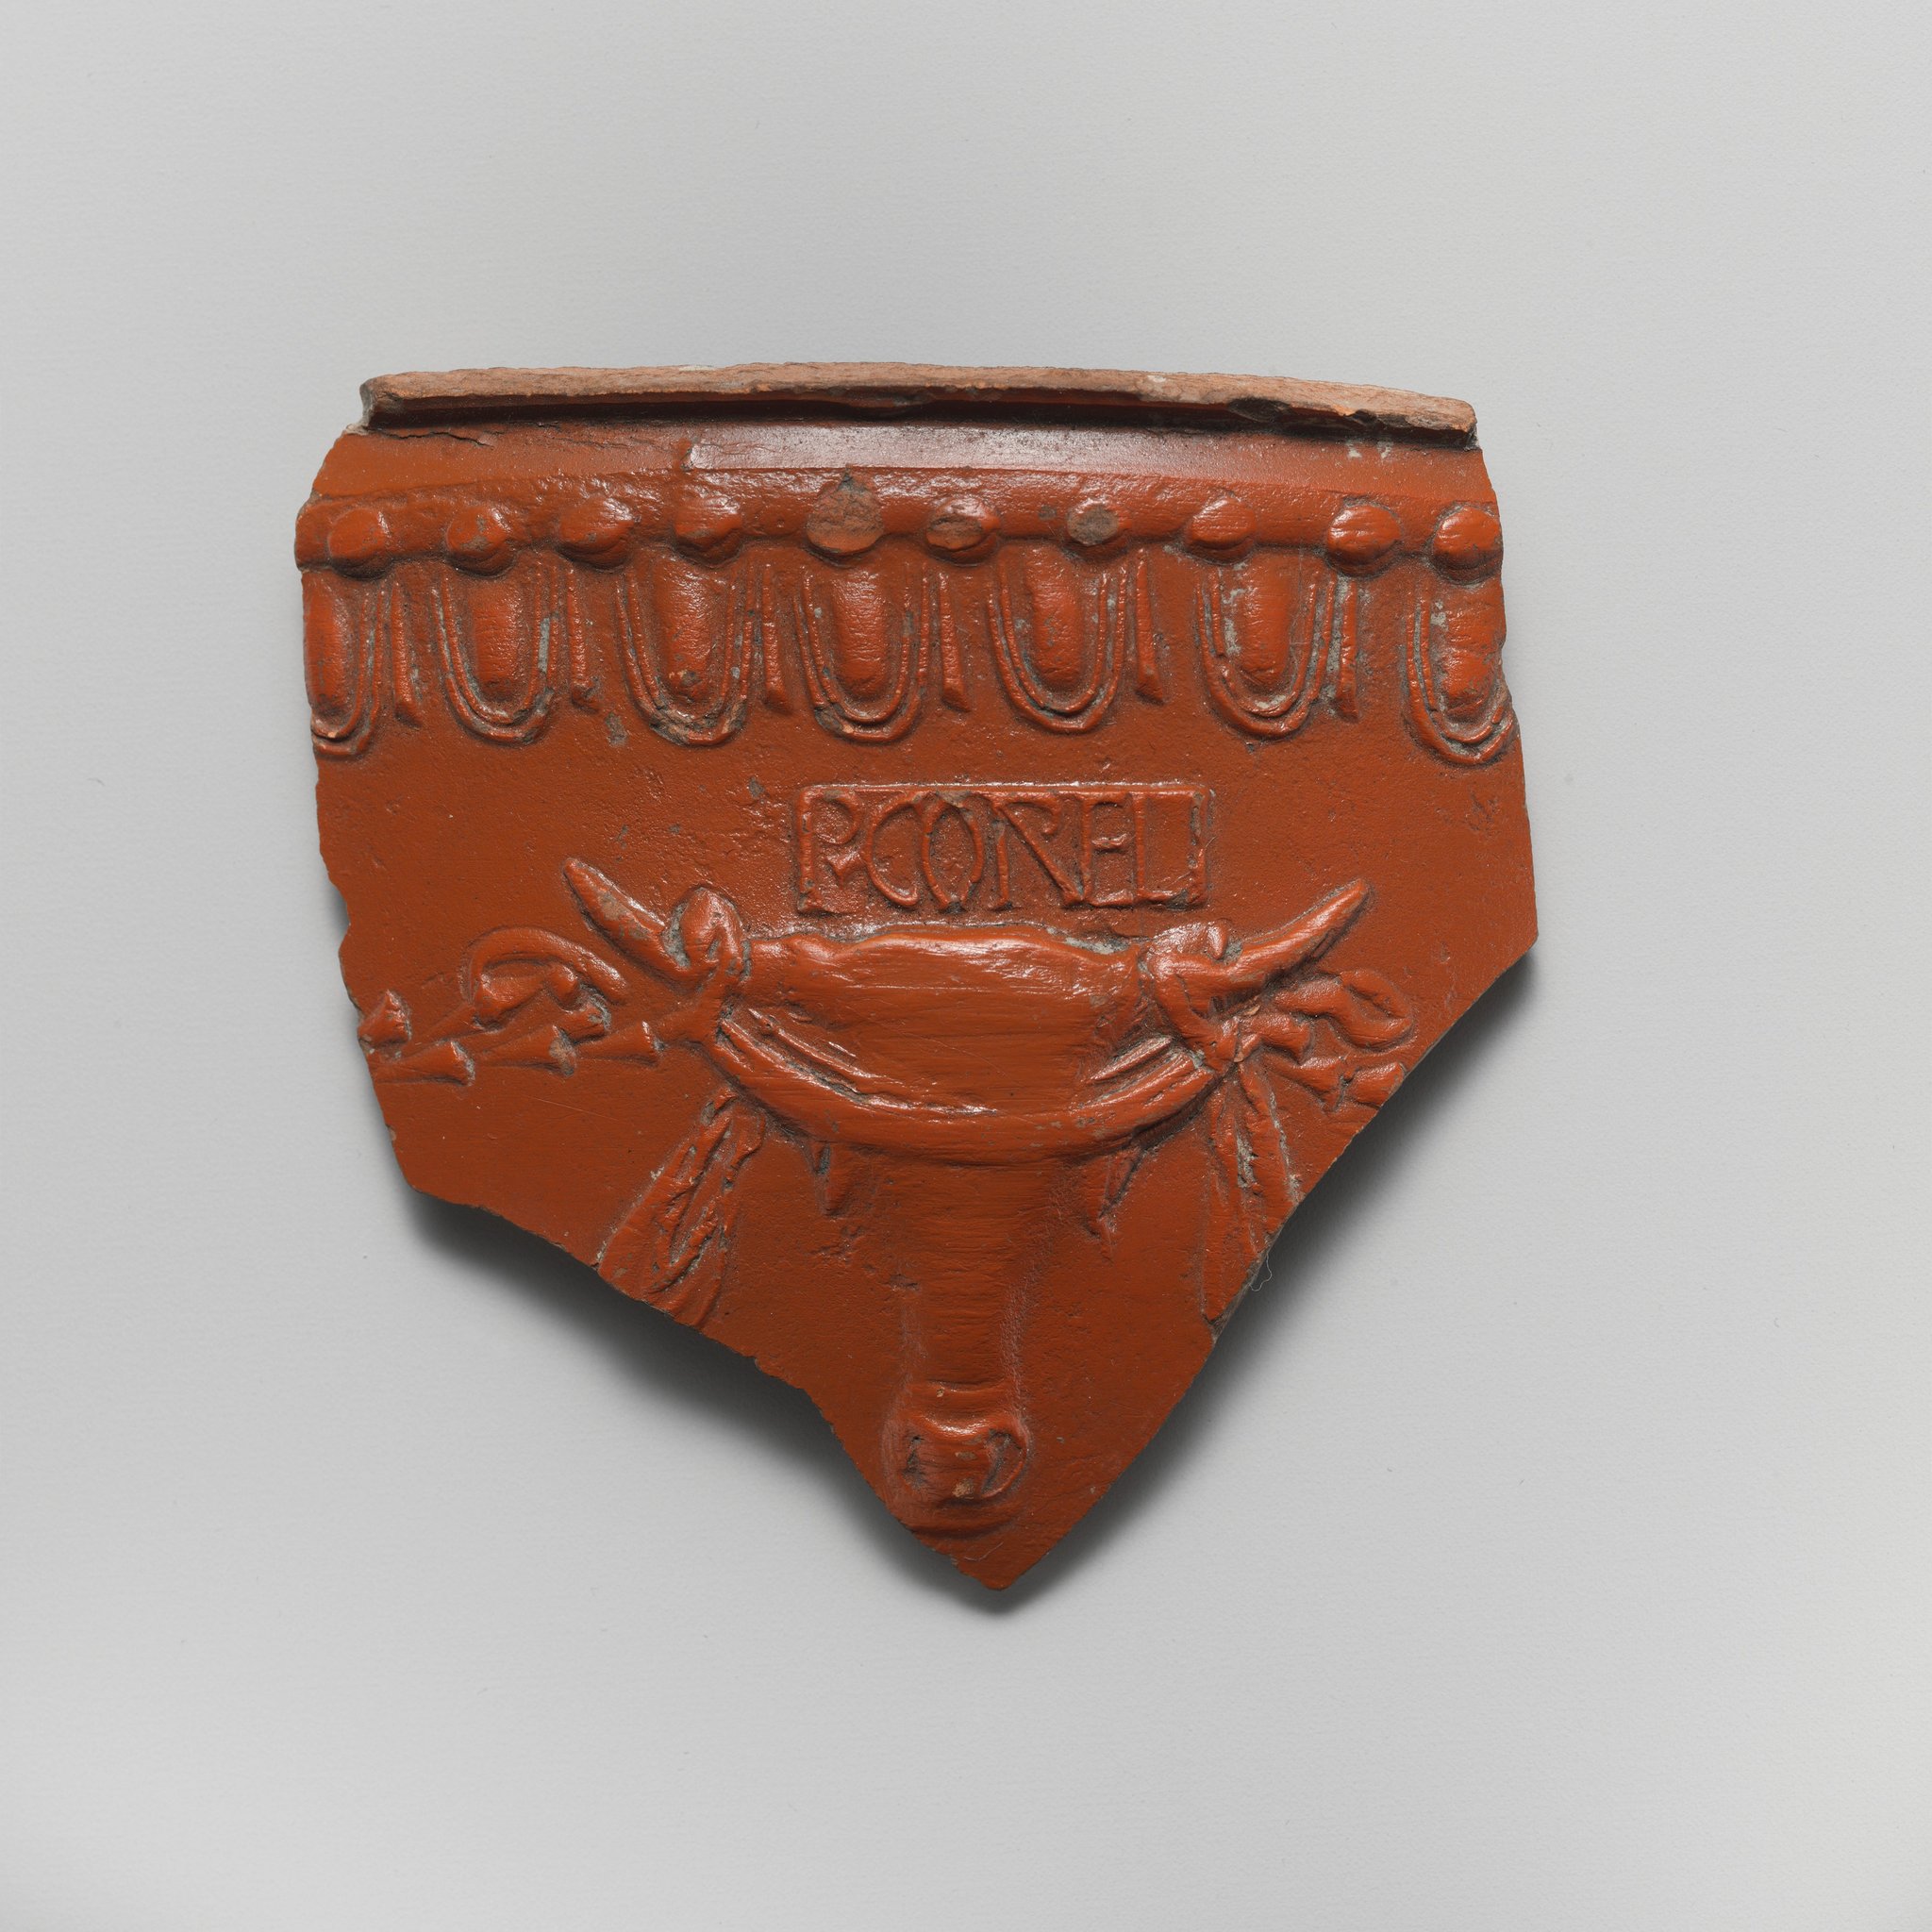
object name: vase fragment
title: Terracotta vase fragment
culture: roman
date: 5 BCE-40 CE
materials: terracotta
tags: animals